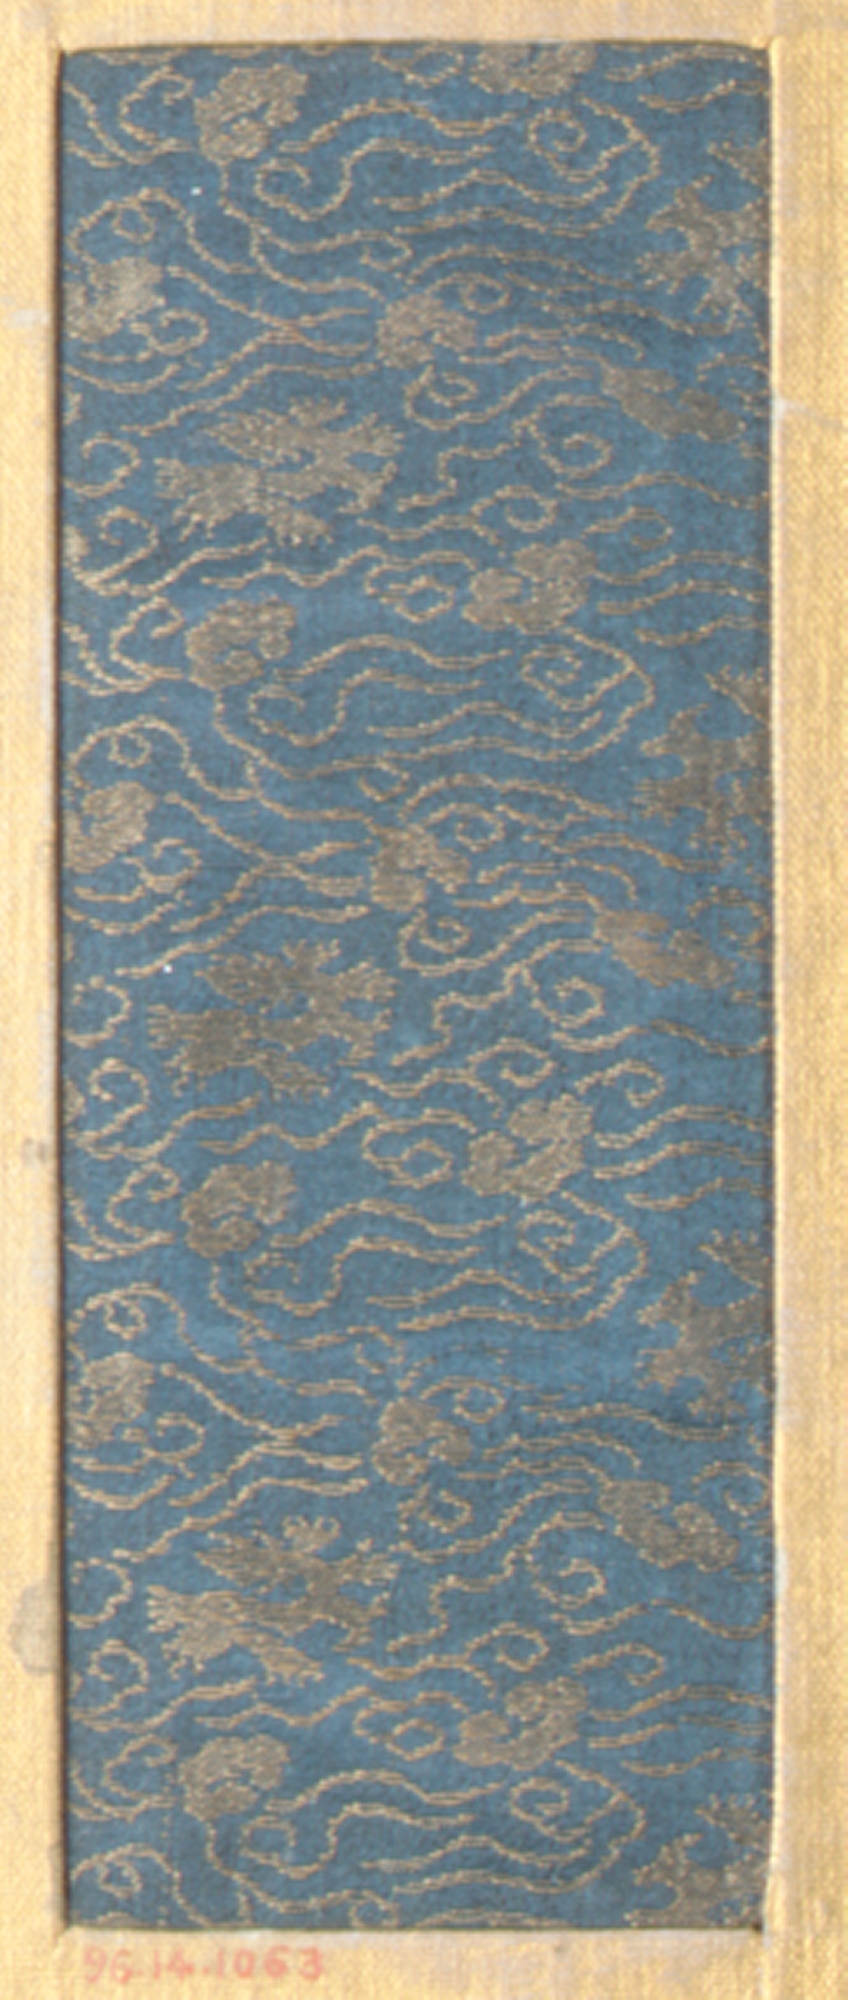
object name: piece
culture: japanese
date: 1701-1900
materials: silk